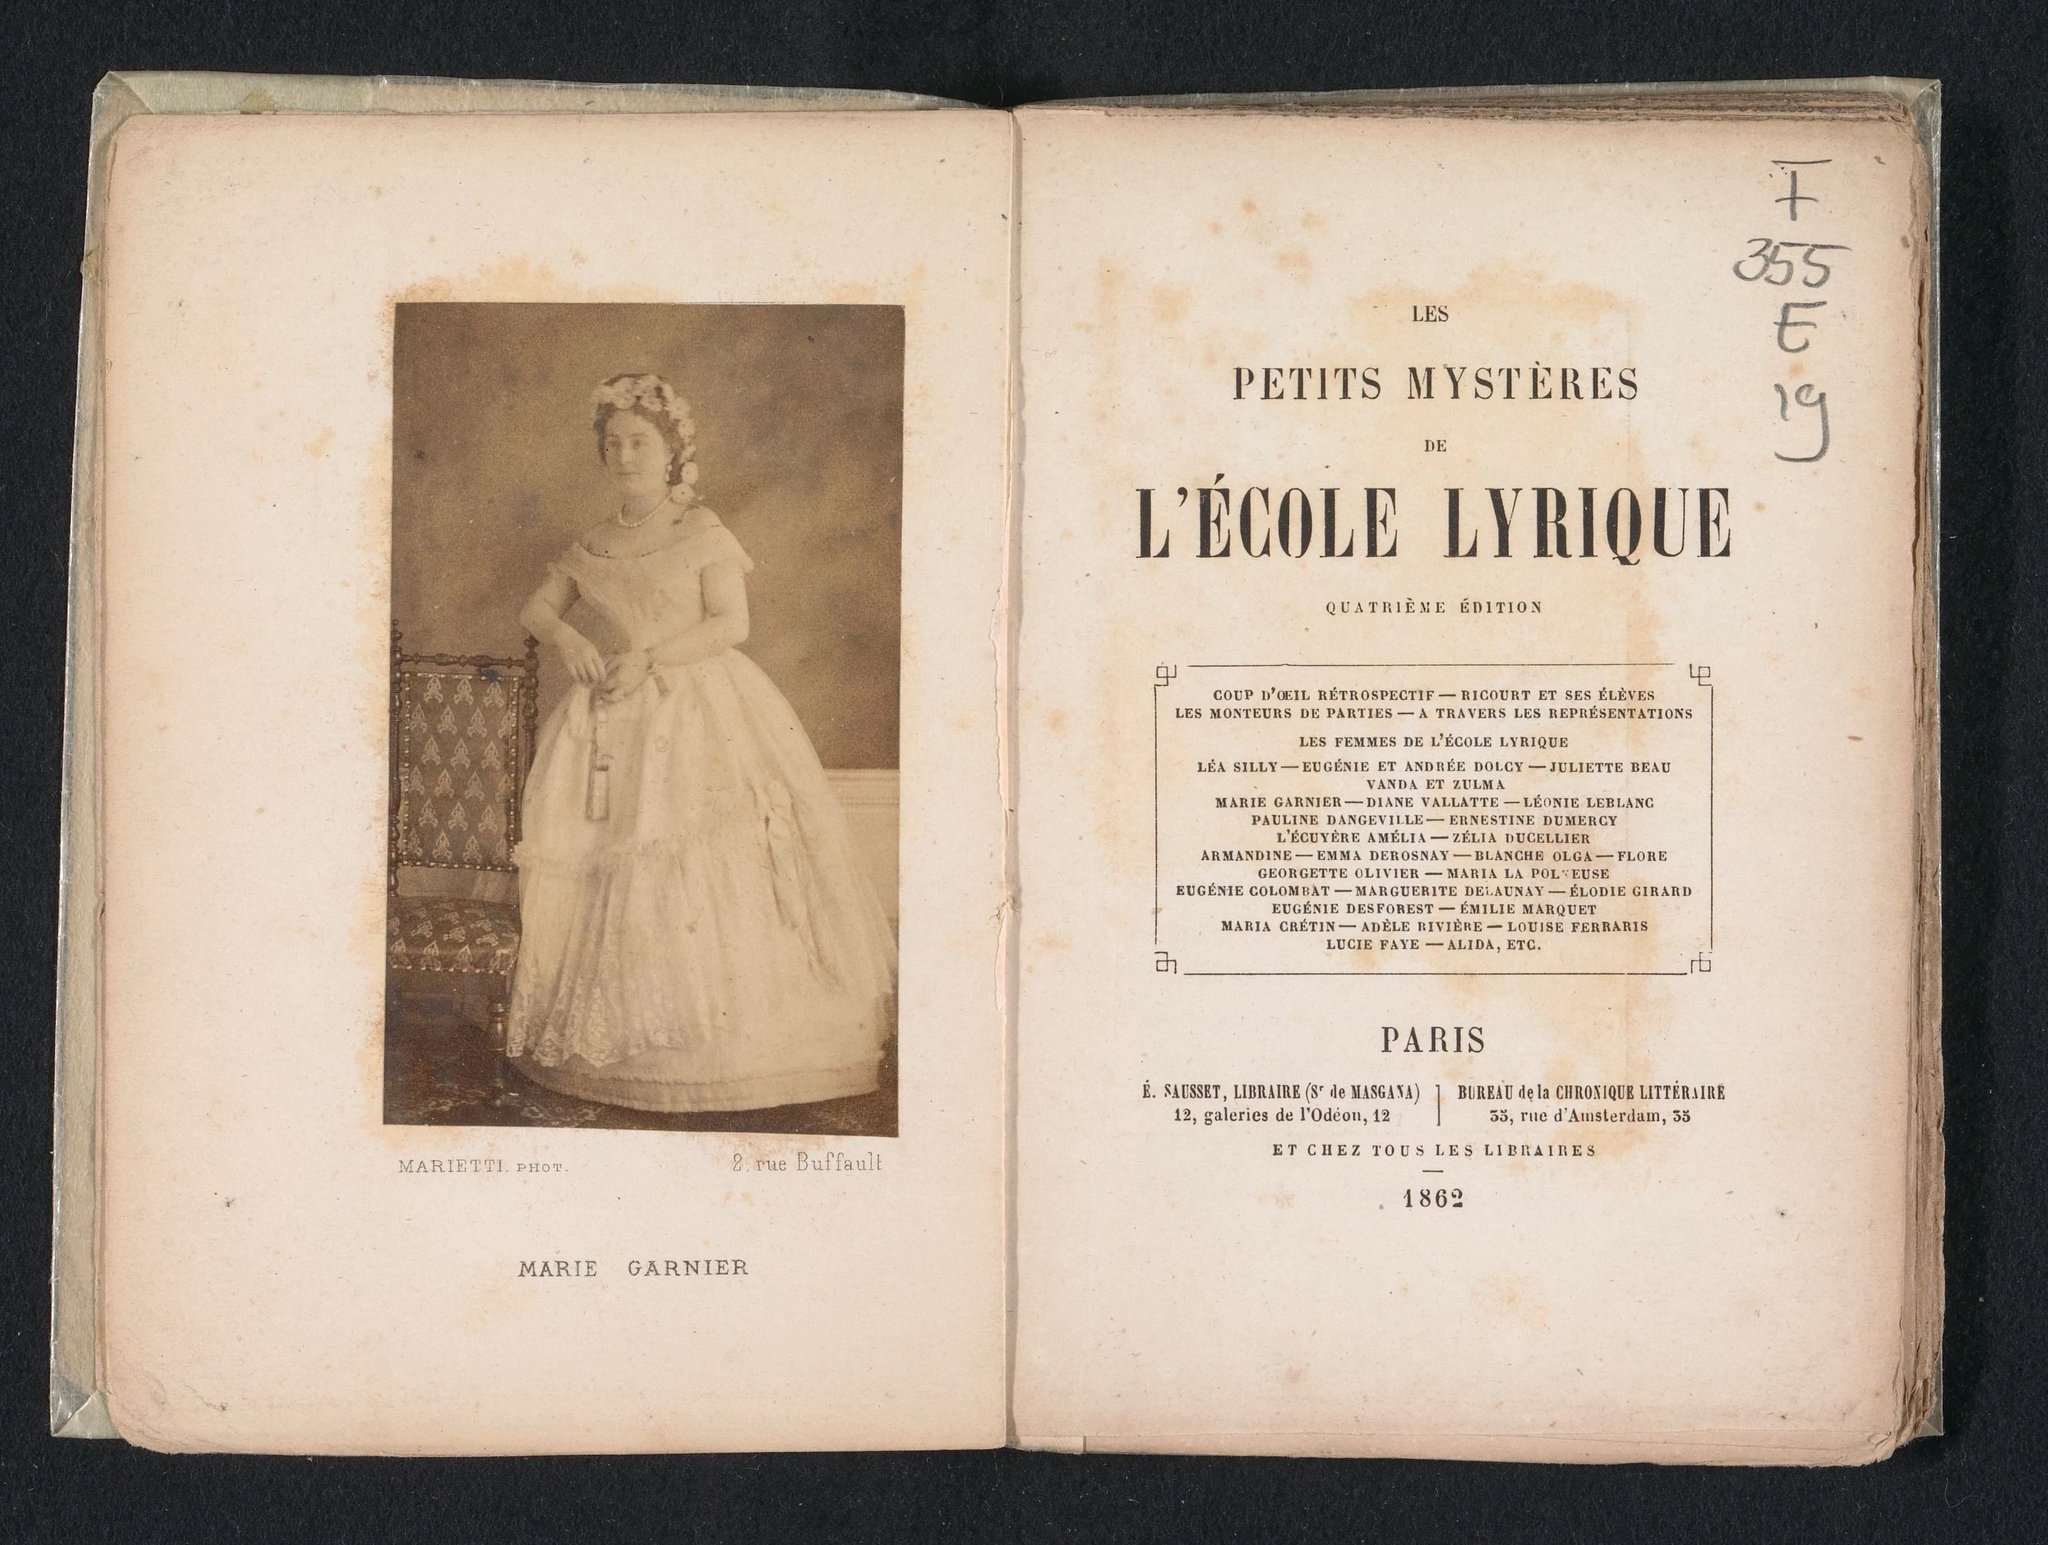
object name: page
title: Marie Garnier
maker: marietti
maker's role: fotograaf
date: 1852-1862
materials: photographic support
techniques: albumen print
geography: paris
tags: adult woman